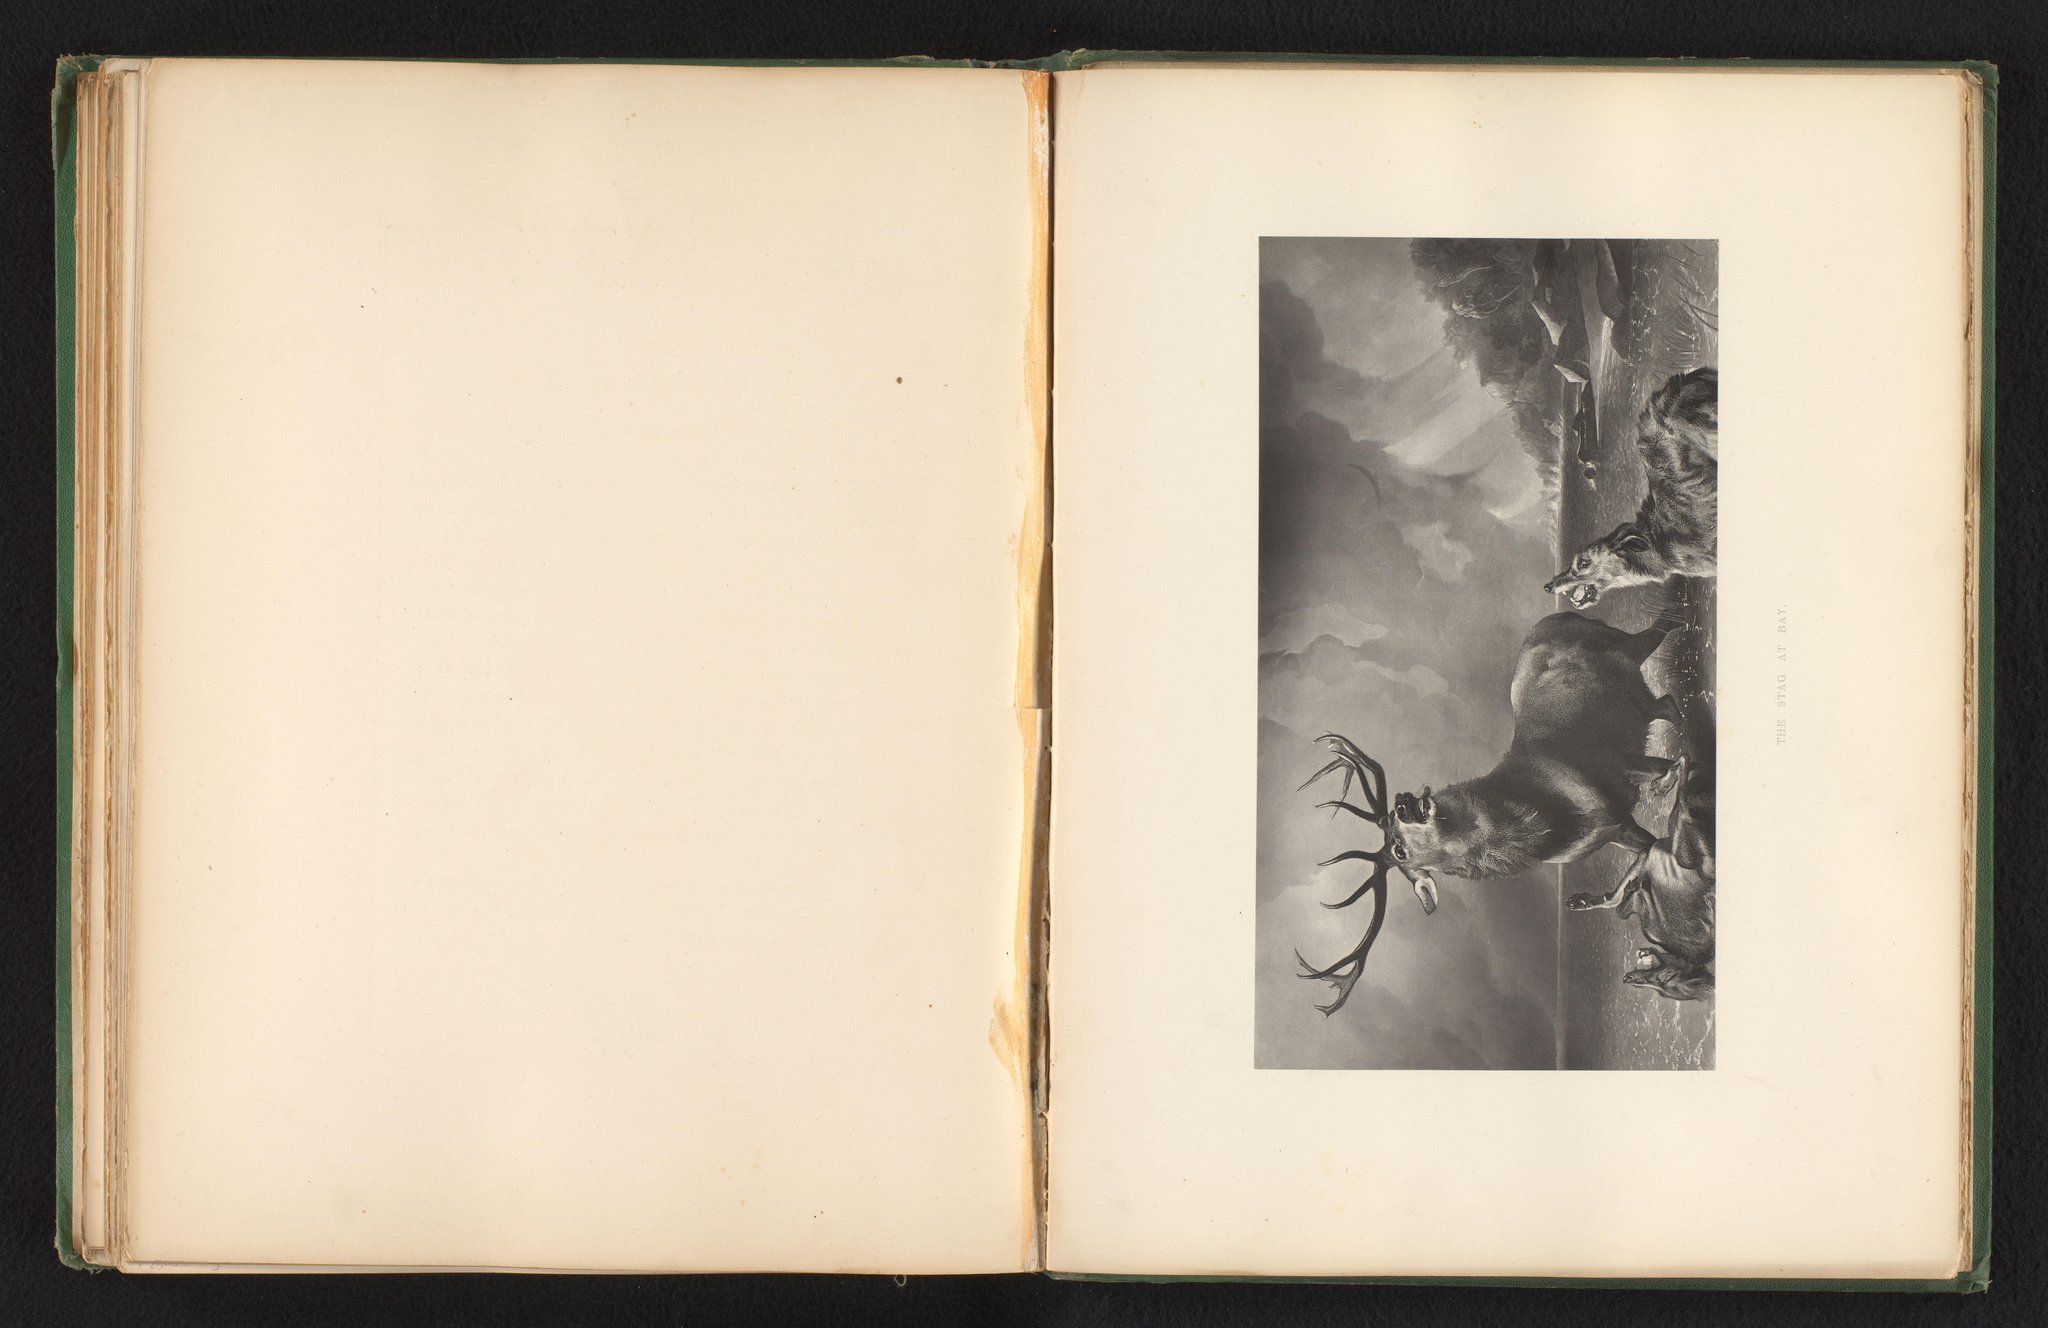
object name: reproduction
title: The stag at bay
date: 1878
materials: paper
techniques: woodburytype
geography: london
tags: gulf, bay, hoofed animals: stag